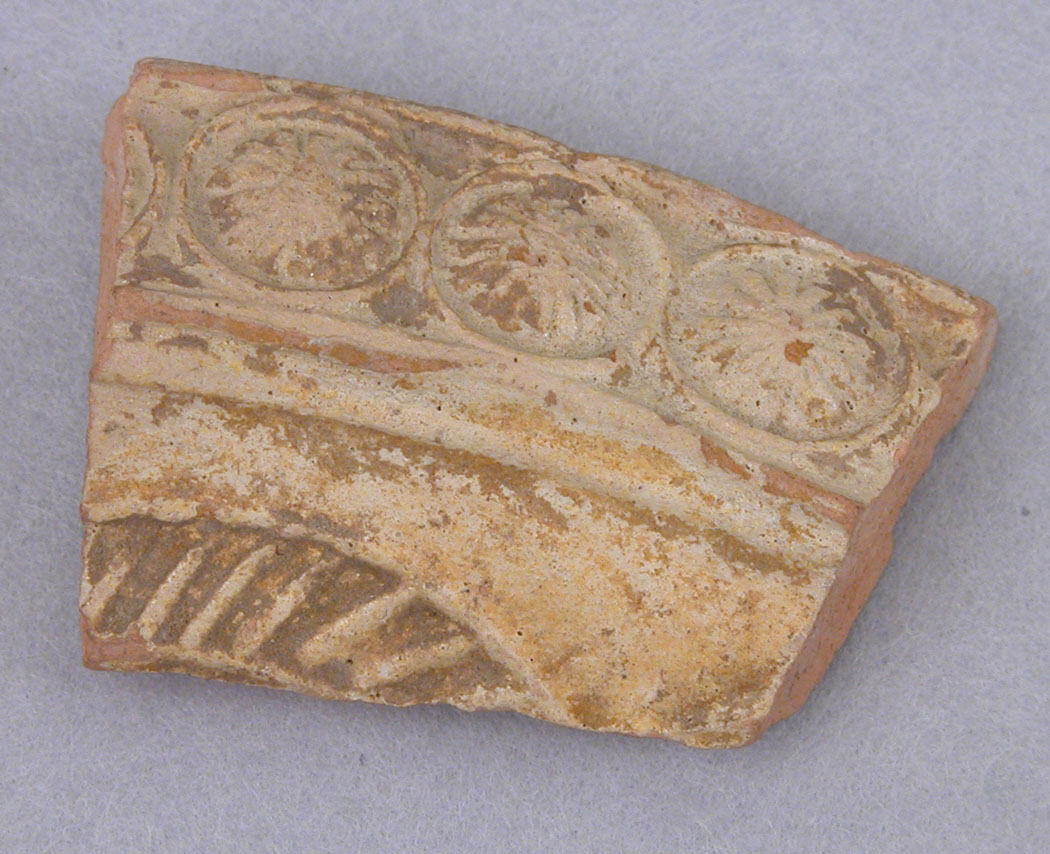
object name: fragment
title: Fragments of Molded Glazed Ceramics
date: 801-900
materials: earthenware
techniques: glazing, molding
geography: iraq